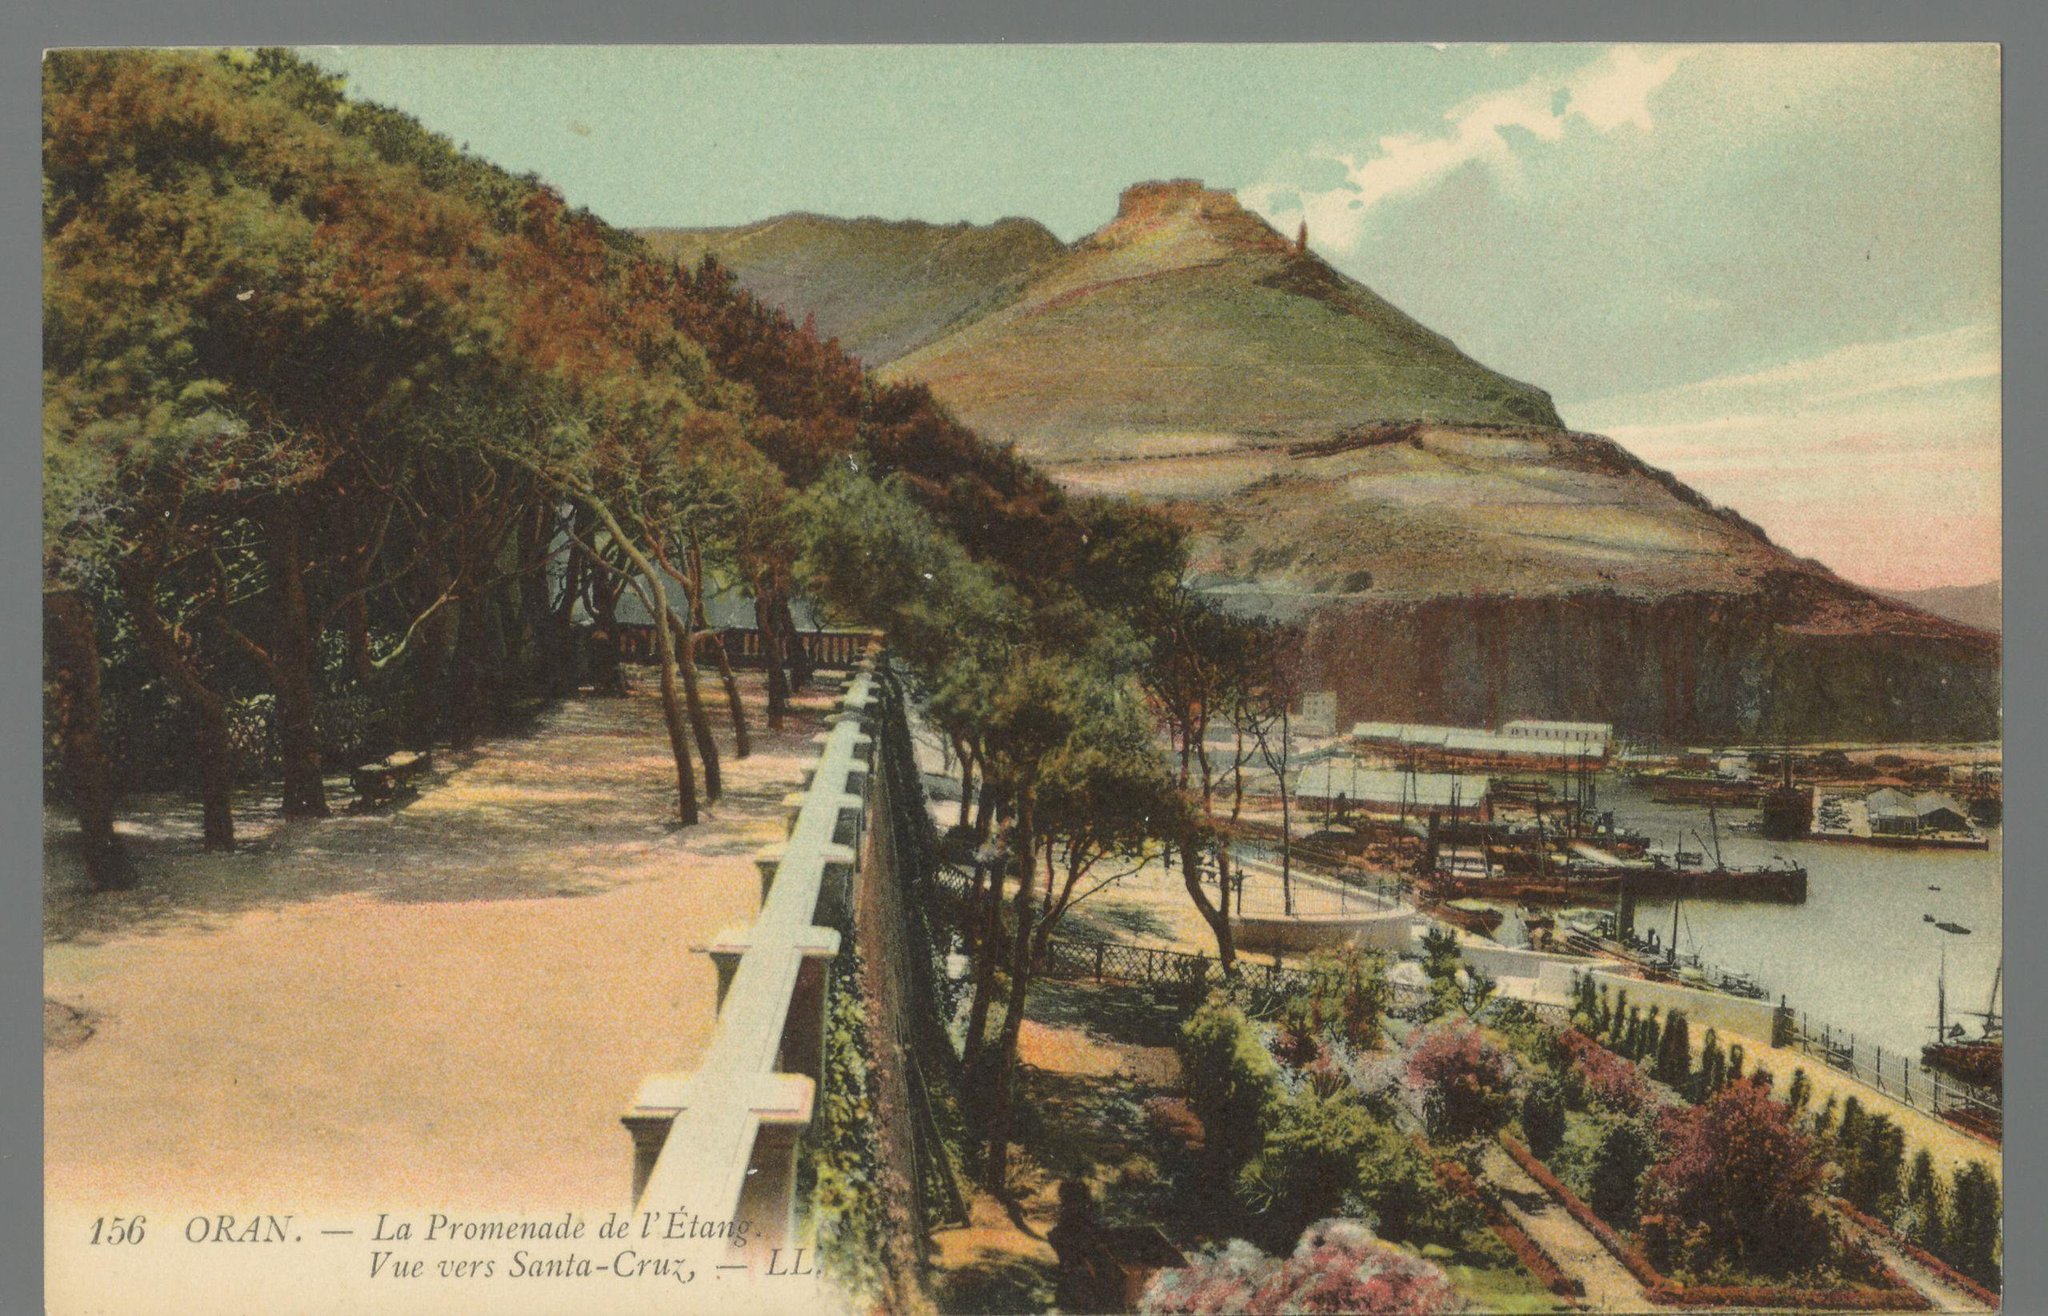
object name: photomechanical print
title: Oran. La Promenade de l'Étang. Vue vers Santa-Cruz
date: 1903-1905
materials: cardboard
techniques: photograph, lithograph, writing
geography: paris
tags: avenue, boulevard, promenade, esplanade, public gardens, park, mountains (in tropical and sub-tropical regions)